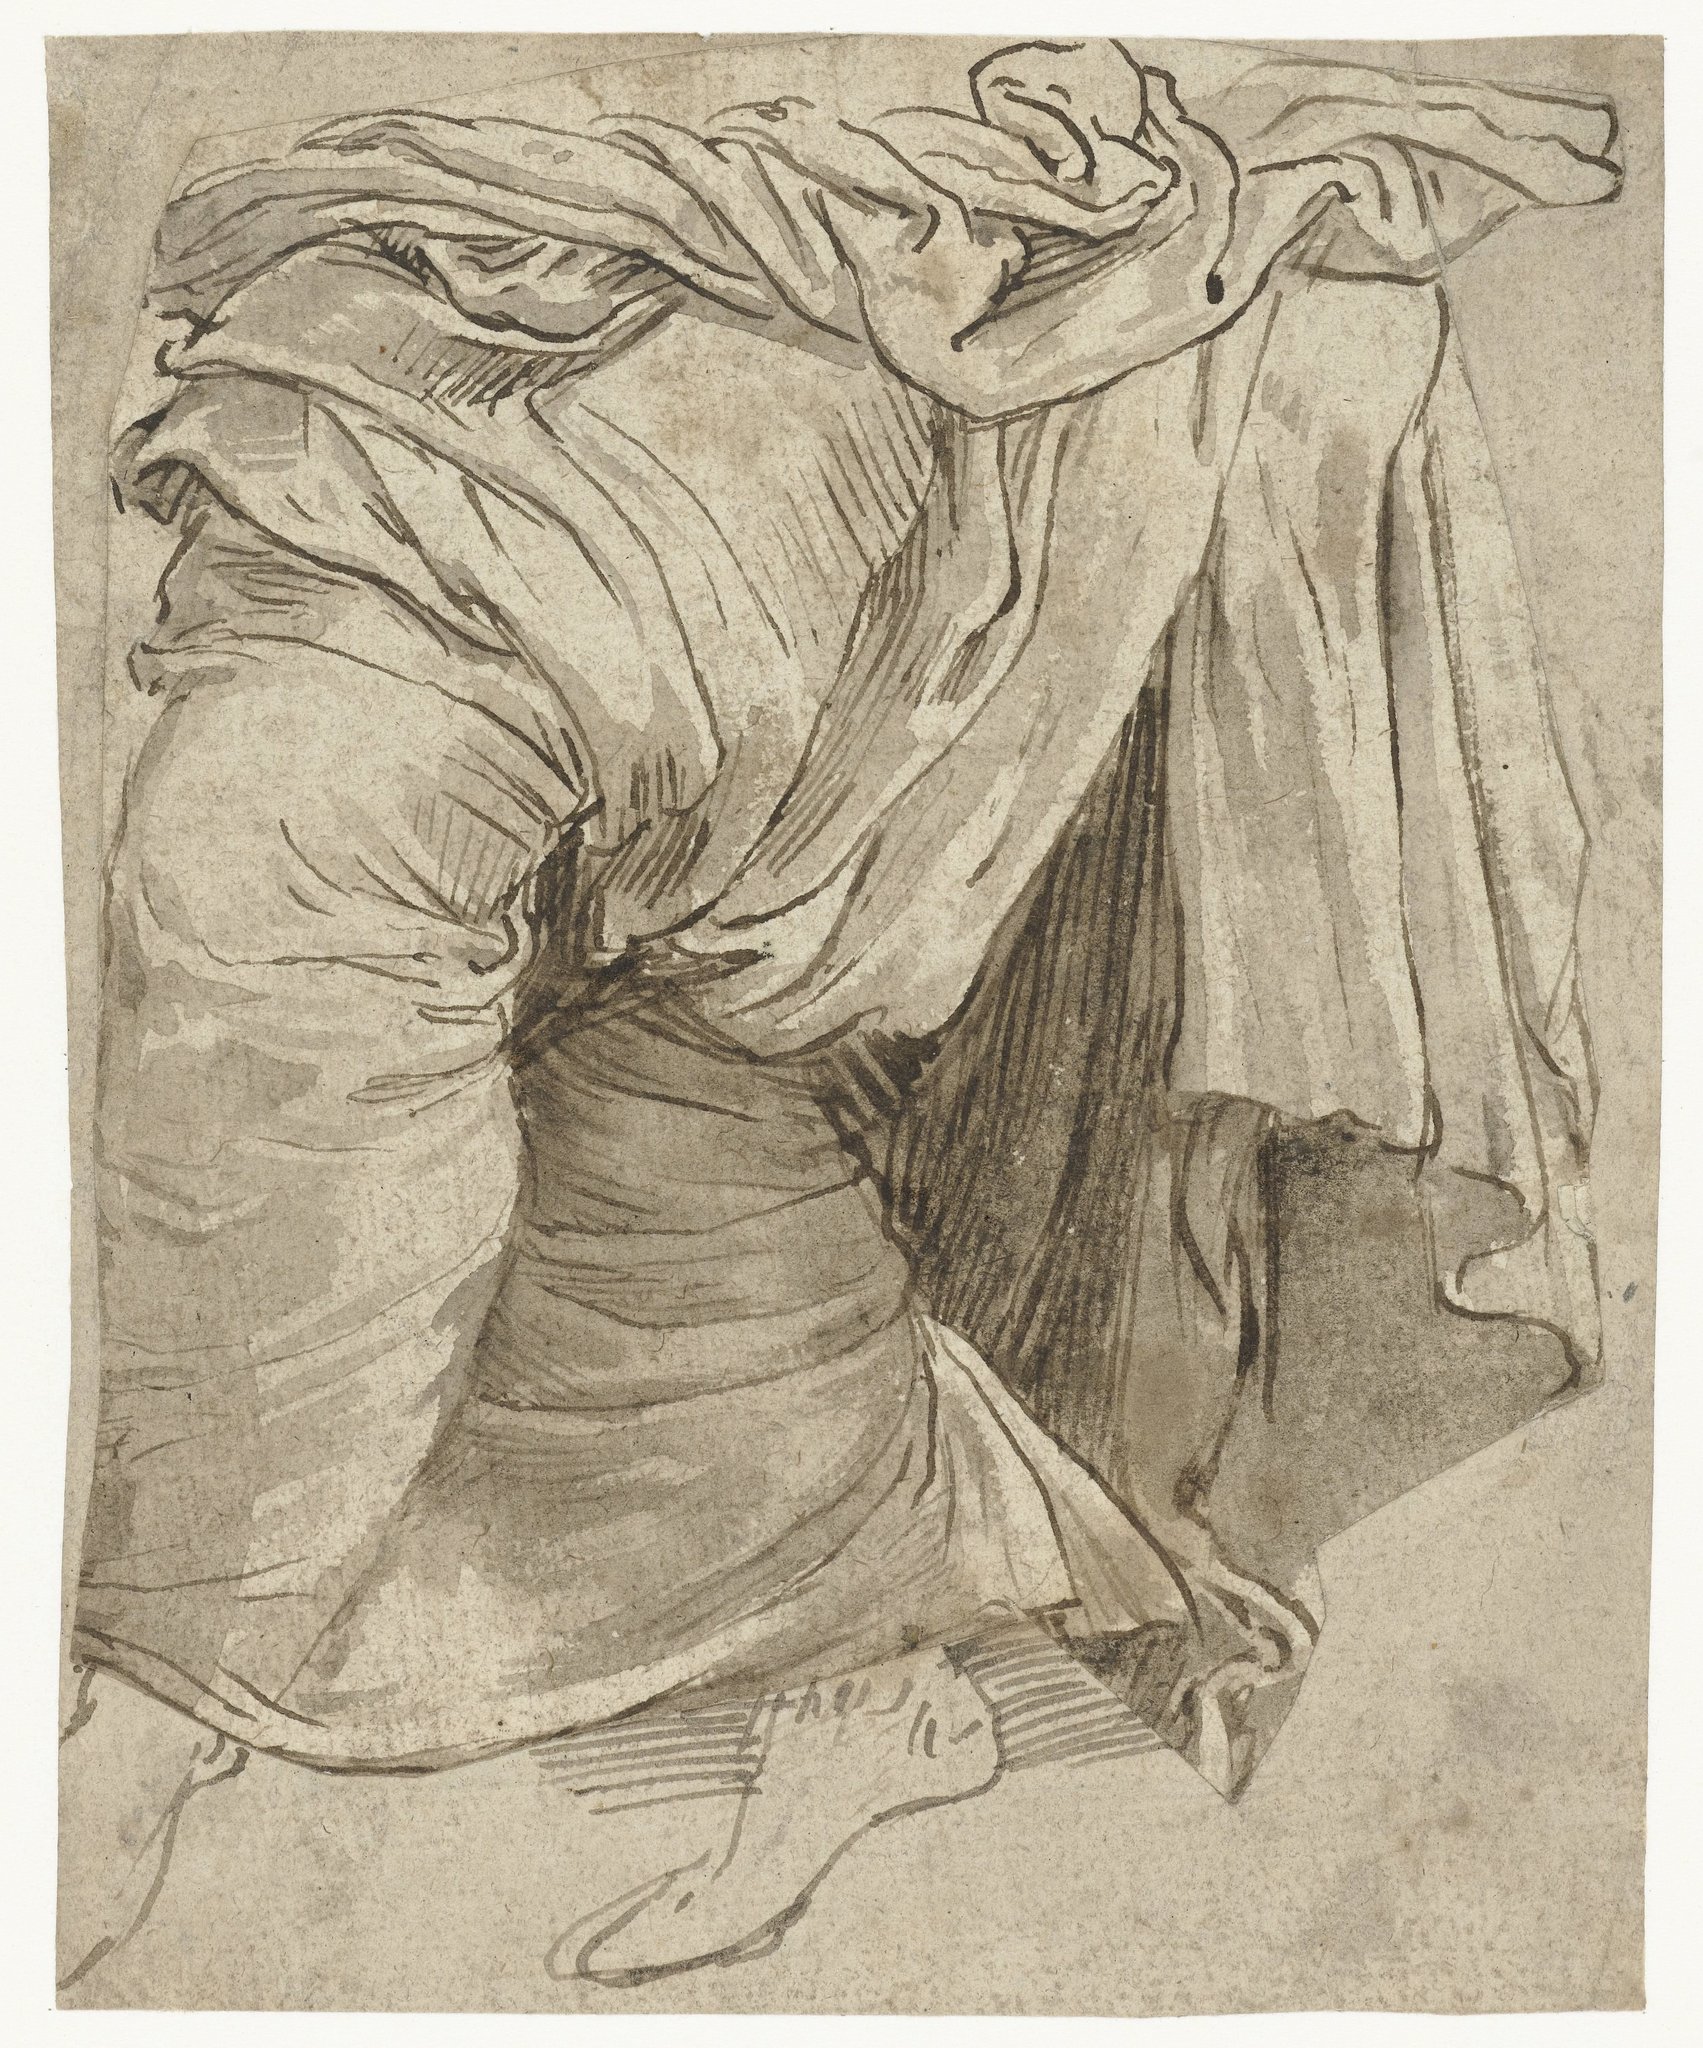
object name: drawing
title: Studie van een draperie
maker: lambert lombard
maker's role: draughtsman, print maker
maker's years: 1505-1566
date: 1516-1566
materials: ink, paper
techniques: brush, pen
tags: drapery, draped garment, 'gewandgebung'